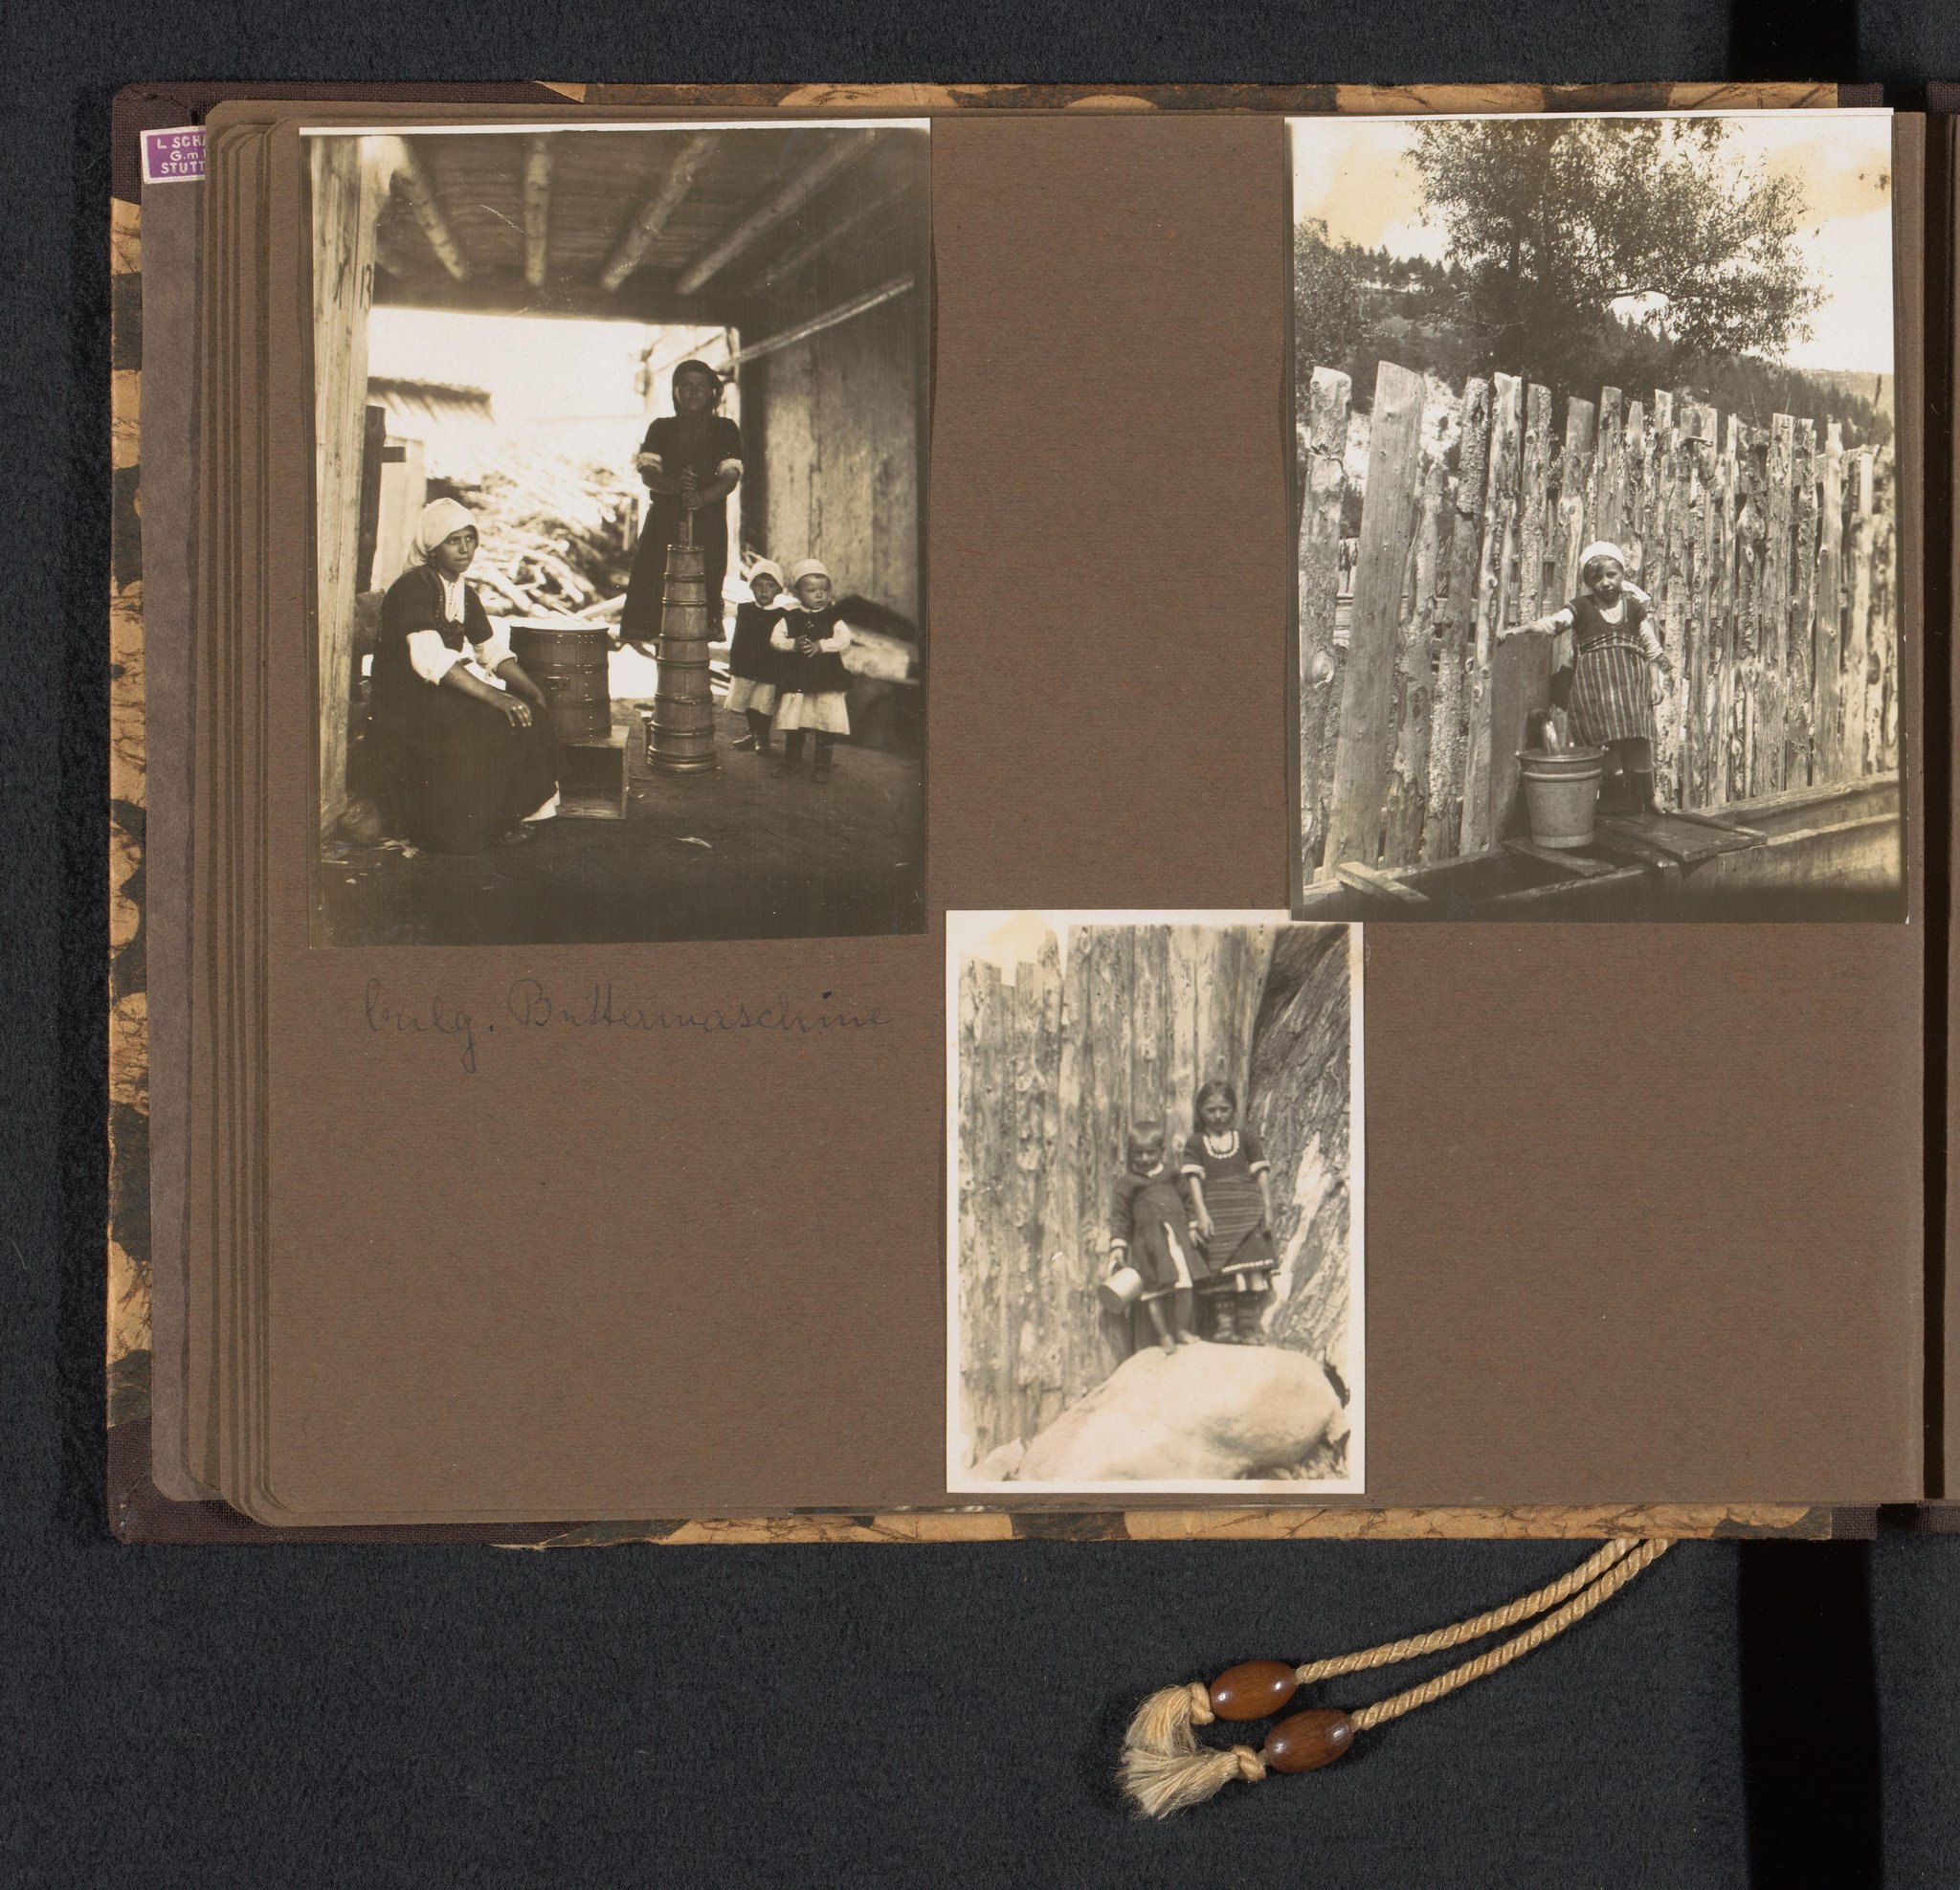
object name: album leaf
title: Bulgaarse kinderen en volwassenen in een Bulgaars dorp tijdens een rondreis van Else Wachenheimer-Moos en haar echtgenoot Eugen Wachenheimer, 1926-1927, Bulgarije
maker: else wachenheimer-moos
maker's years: 1895-1944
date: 1926-1927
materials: paper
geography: bulgaria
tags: bulgarije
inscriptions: inscription: ‘bulg. buttermaschine’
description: Albumblad bevat drie foto's. Zonder personen gerelateerd aan de familie Wachenheimer. Afkomstig uit album half formaat, kartonomslag met koordbinding en lichte veelvormige vormen op voorzijde.